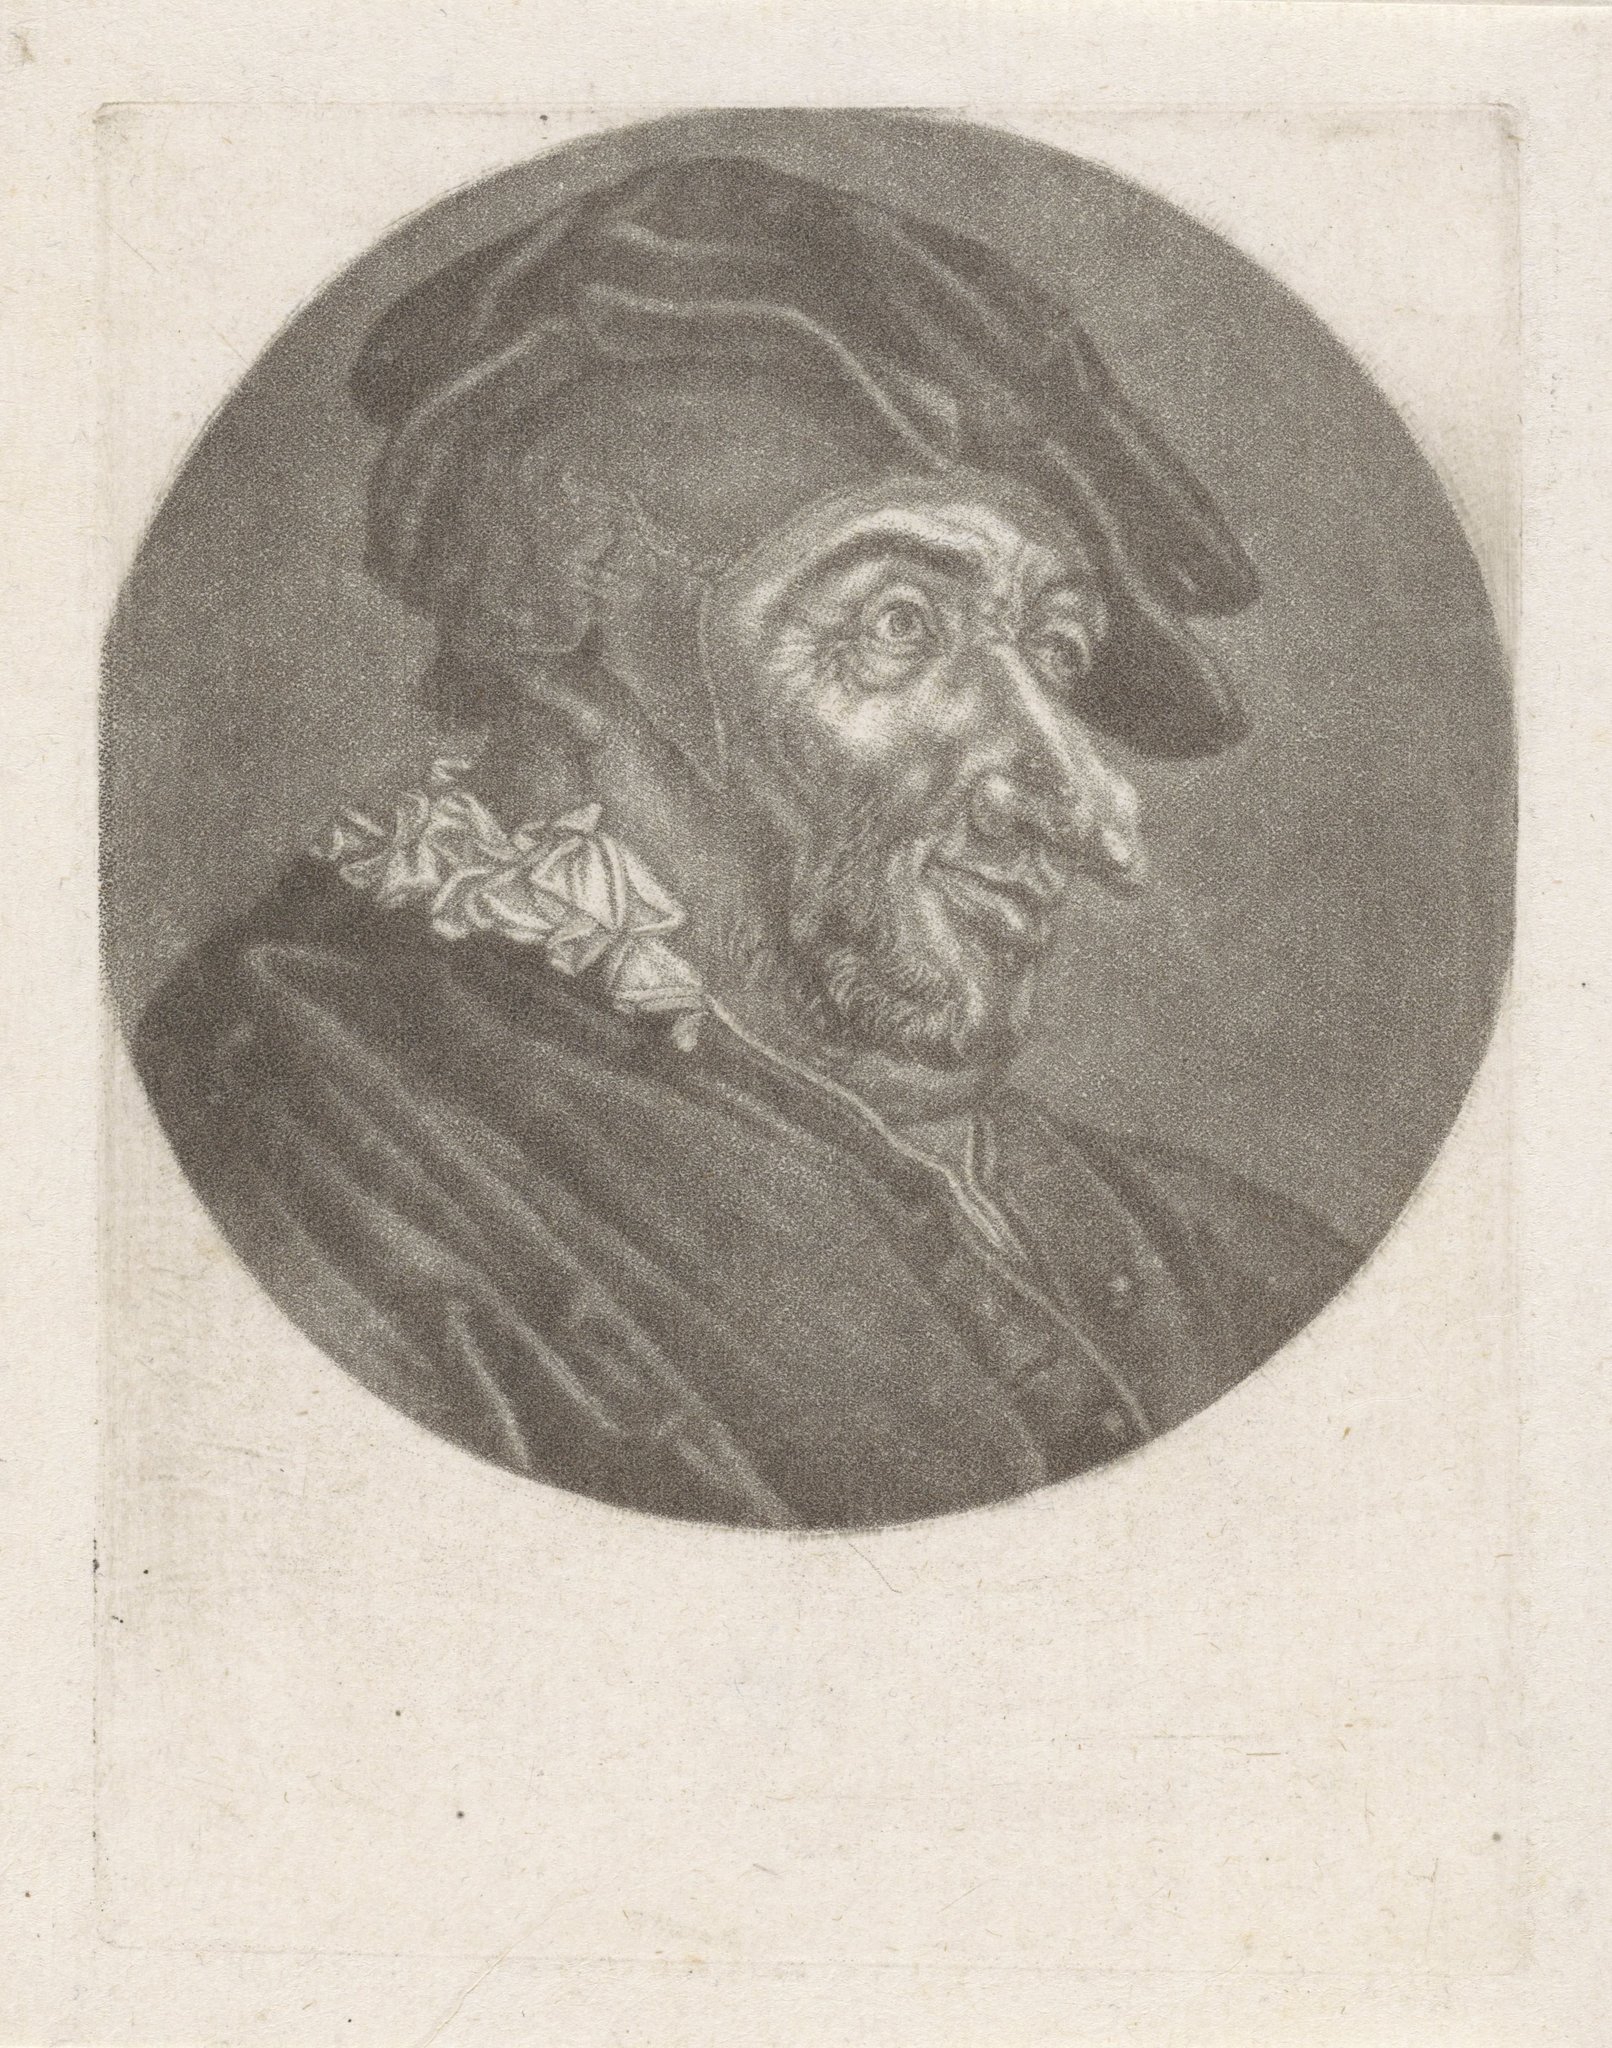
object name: print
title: Kop van een man met een hoed en een neus met pukkels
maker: Anonymous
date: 1650-1800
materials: paper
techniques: mezzotint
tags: head-gear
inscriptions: collector's mark: Lugt 2228